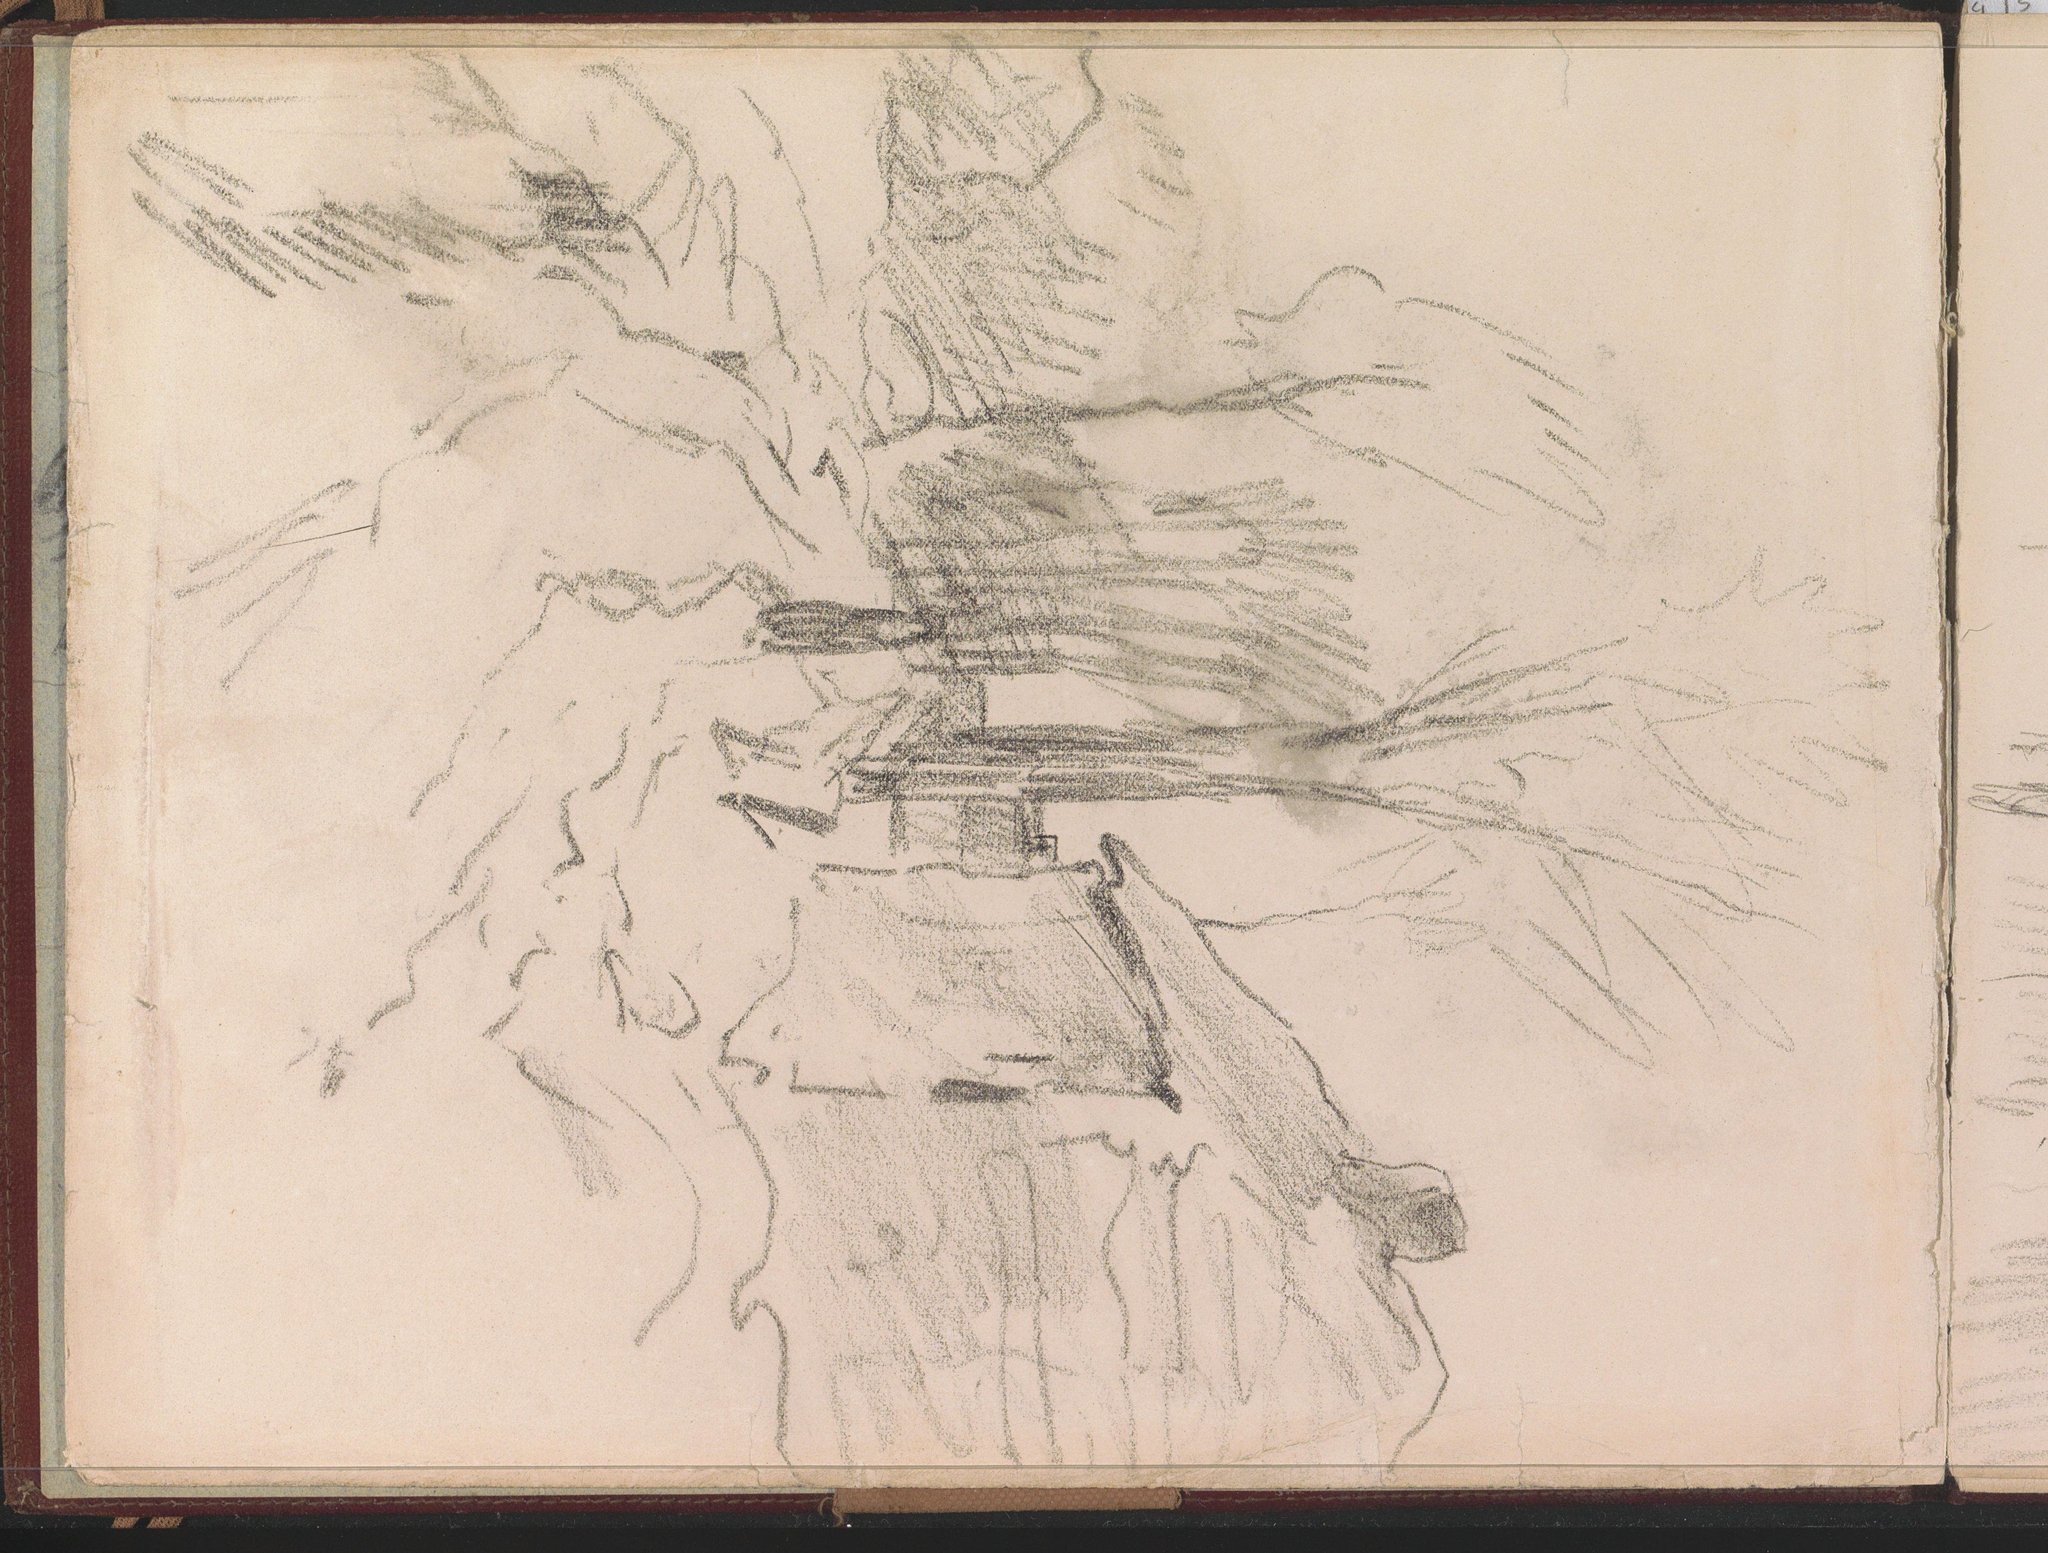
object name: sketchbook leaf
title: Huis met een schoorsteen aan een landweg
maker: anton mauve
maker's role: draughtsman, painter, print maker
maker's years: 1838-1888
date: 1886-1888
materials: chalk, paper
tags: farm or solitary house in landscape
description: Op het pad naar het huis staat mogelijk een figuur. Blad 3 verso uit een schetsboek met 27 bladen.